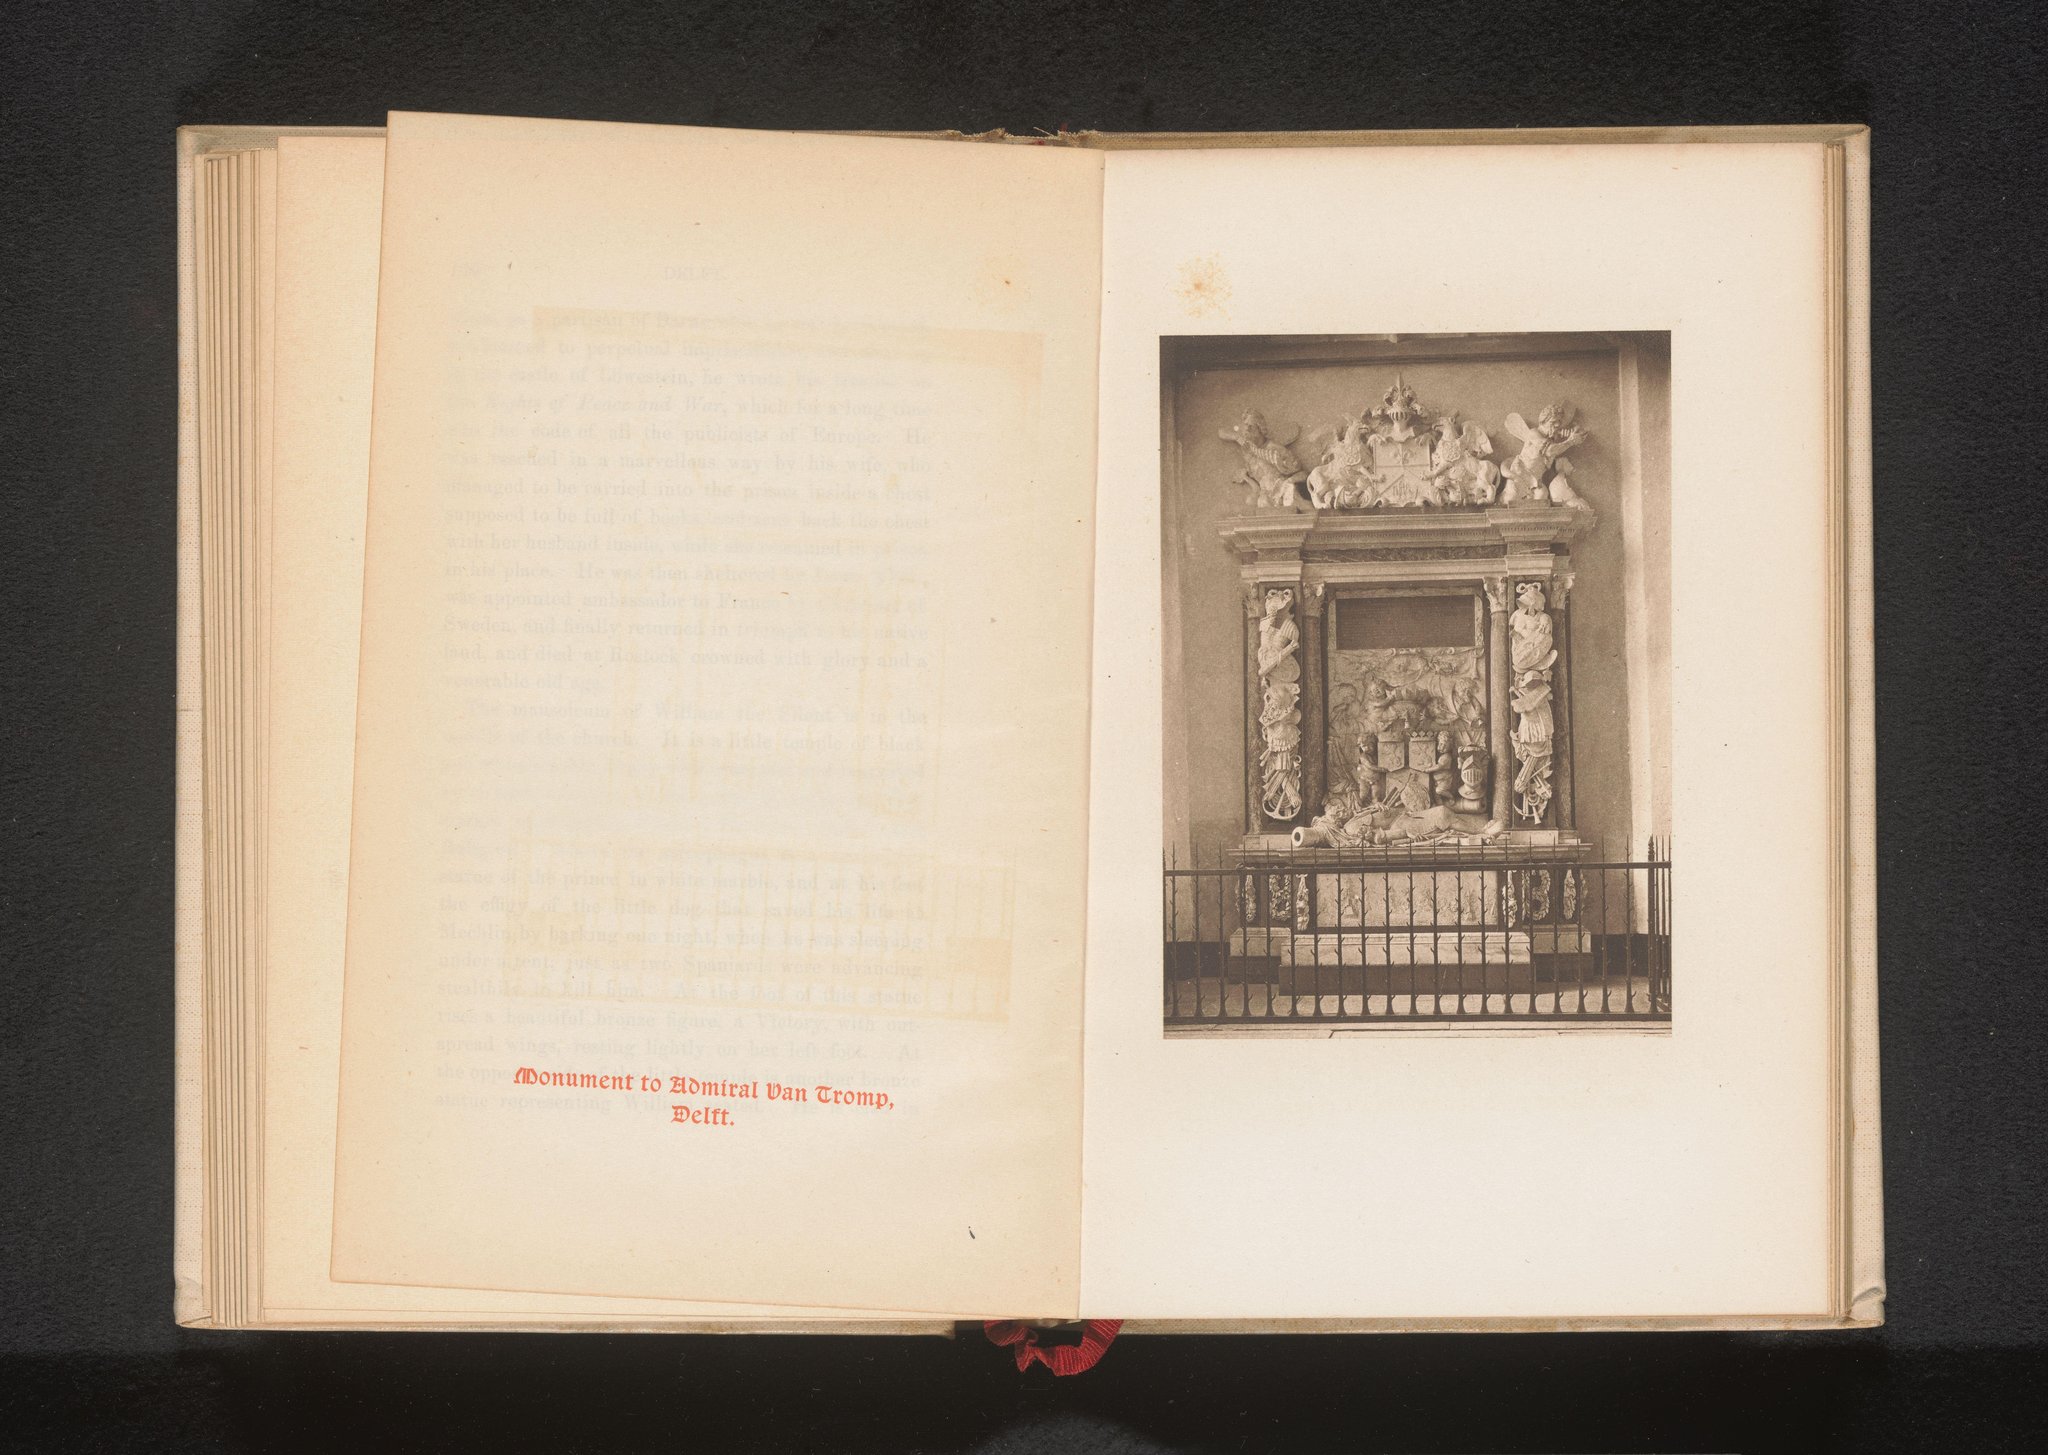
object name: photomechanical print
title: Grafmonument voor Maarten Tromp in de Oude Kerk te Delft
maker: charles l. mitchell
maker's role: fotograaf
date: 1884-1894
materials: paper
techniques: photoaquatint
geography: oude kerk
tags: interior of church, grave-building, monumental tomb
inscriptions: title: ‘Monument to Admiral Van Tromp, Delft.’